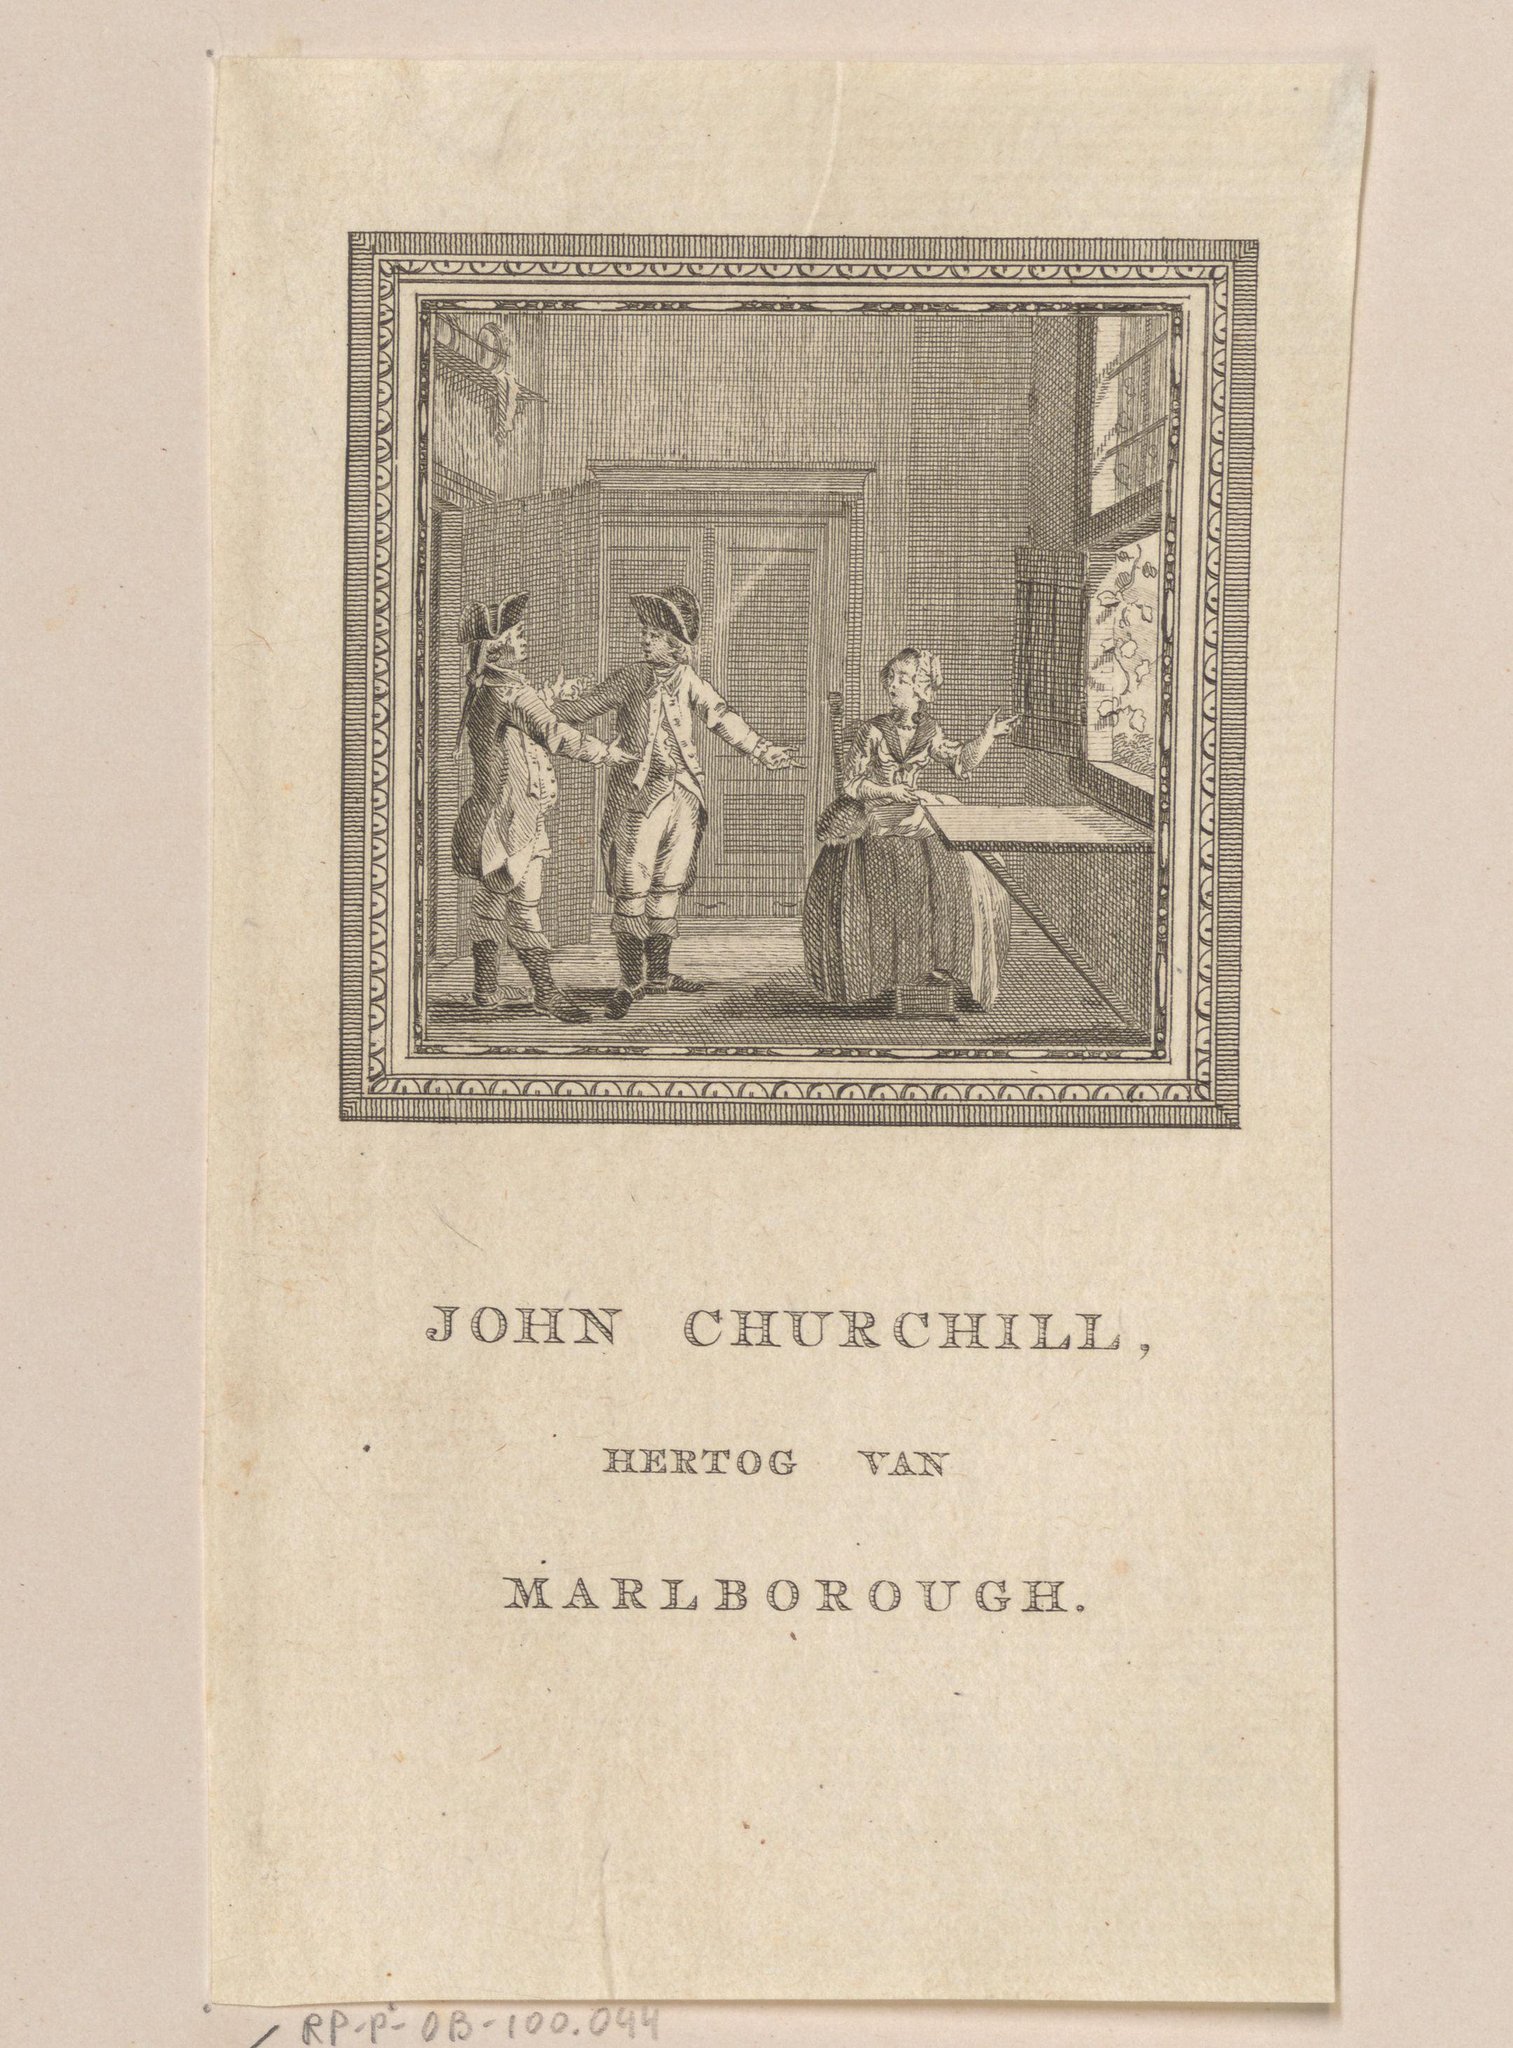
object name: print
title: John Churchill, hertog van Marlborough in een vertrek met een man en een vrouw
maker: Anonymous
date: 1800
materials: paper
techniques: etching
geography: northern netherlands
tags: john churchill (1e hertog van marlborough), historical persons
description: Prent waarschijnlijk uit: Arnaud, François-Thomas-Marie de Baculard d'. Geschenk voor jonge lieden, of Uitgezogte leerzaame verhaalen (...). Amsterdam: Gerbrand Roos, 1800.